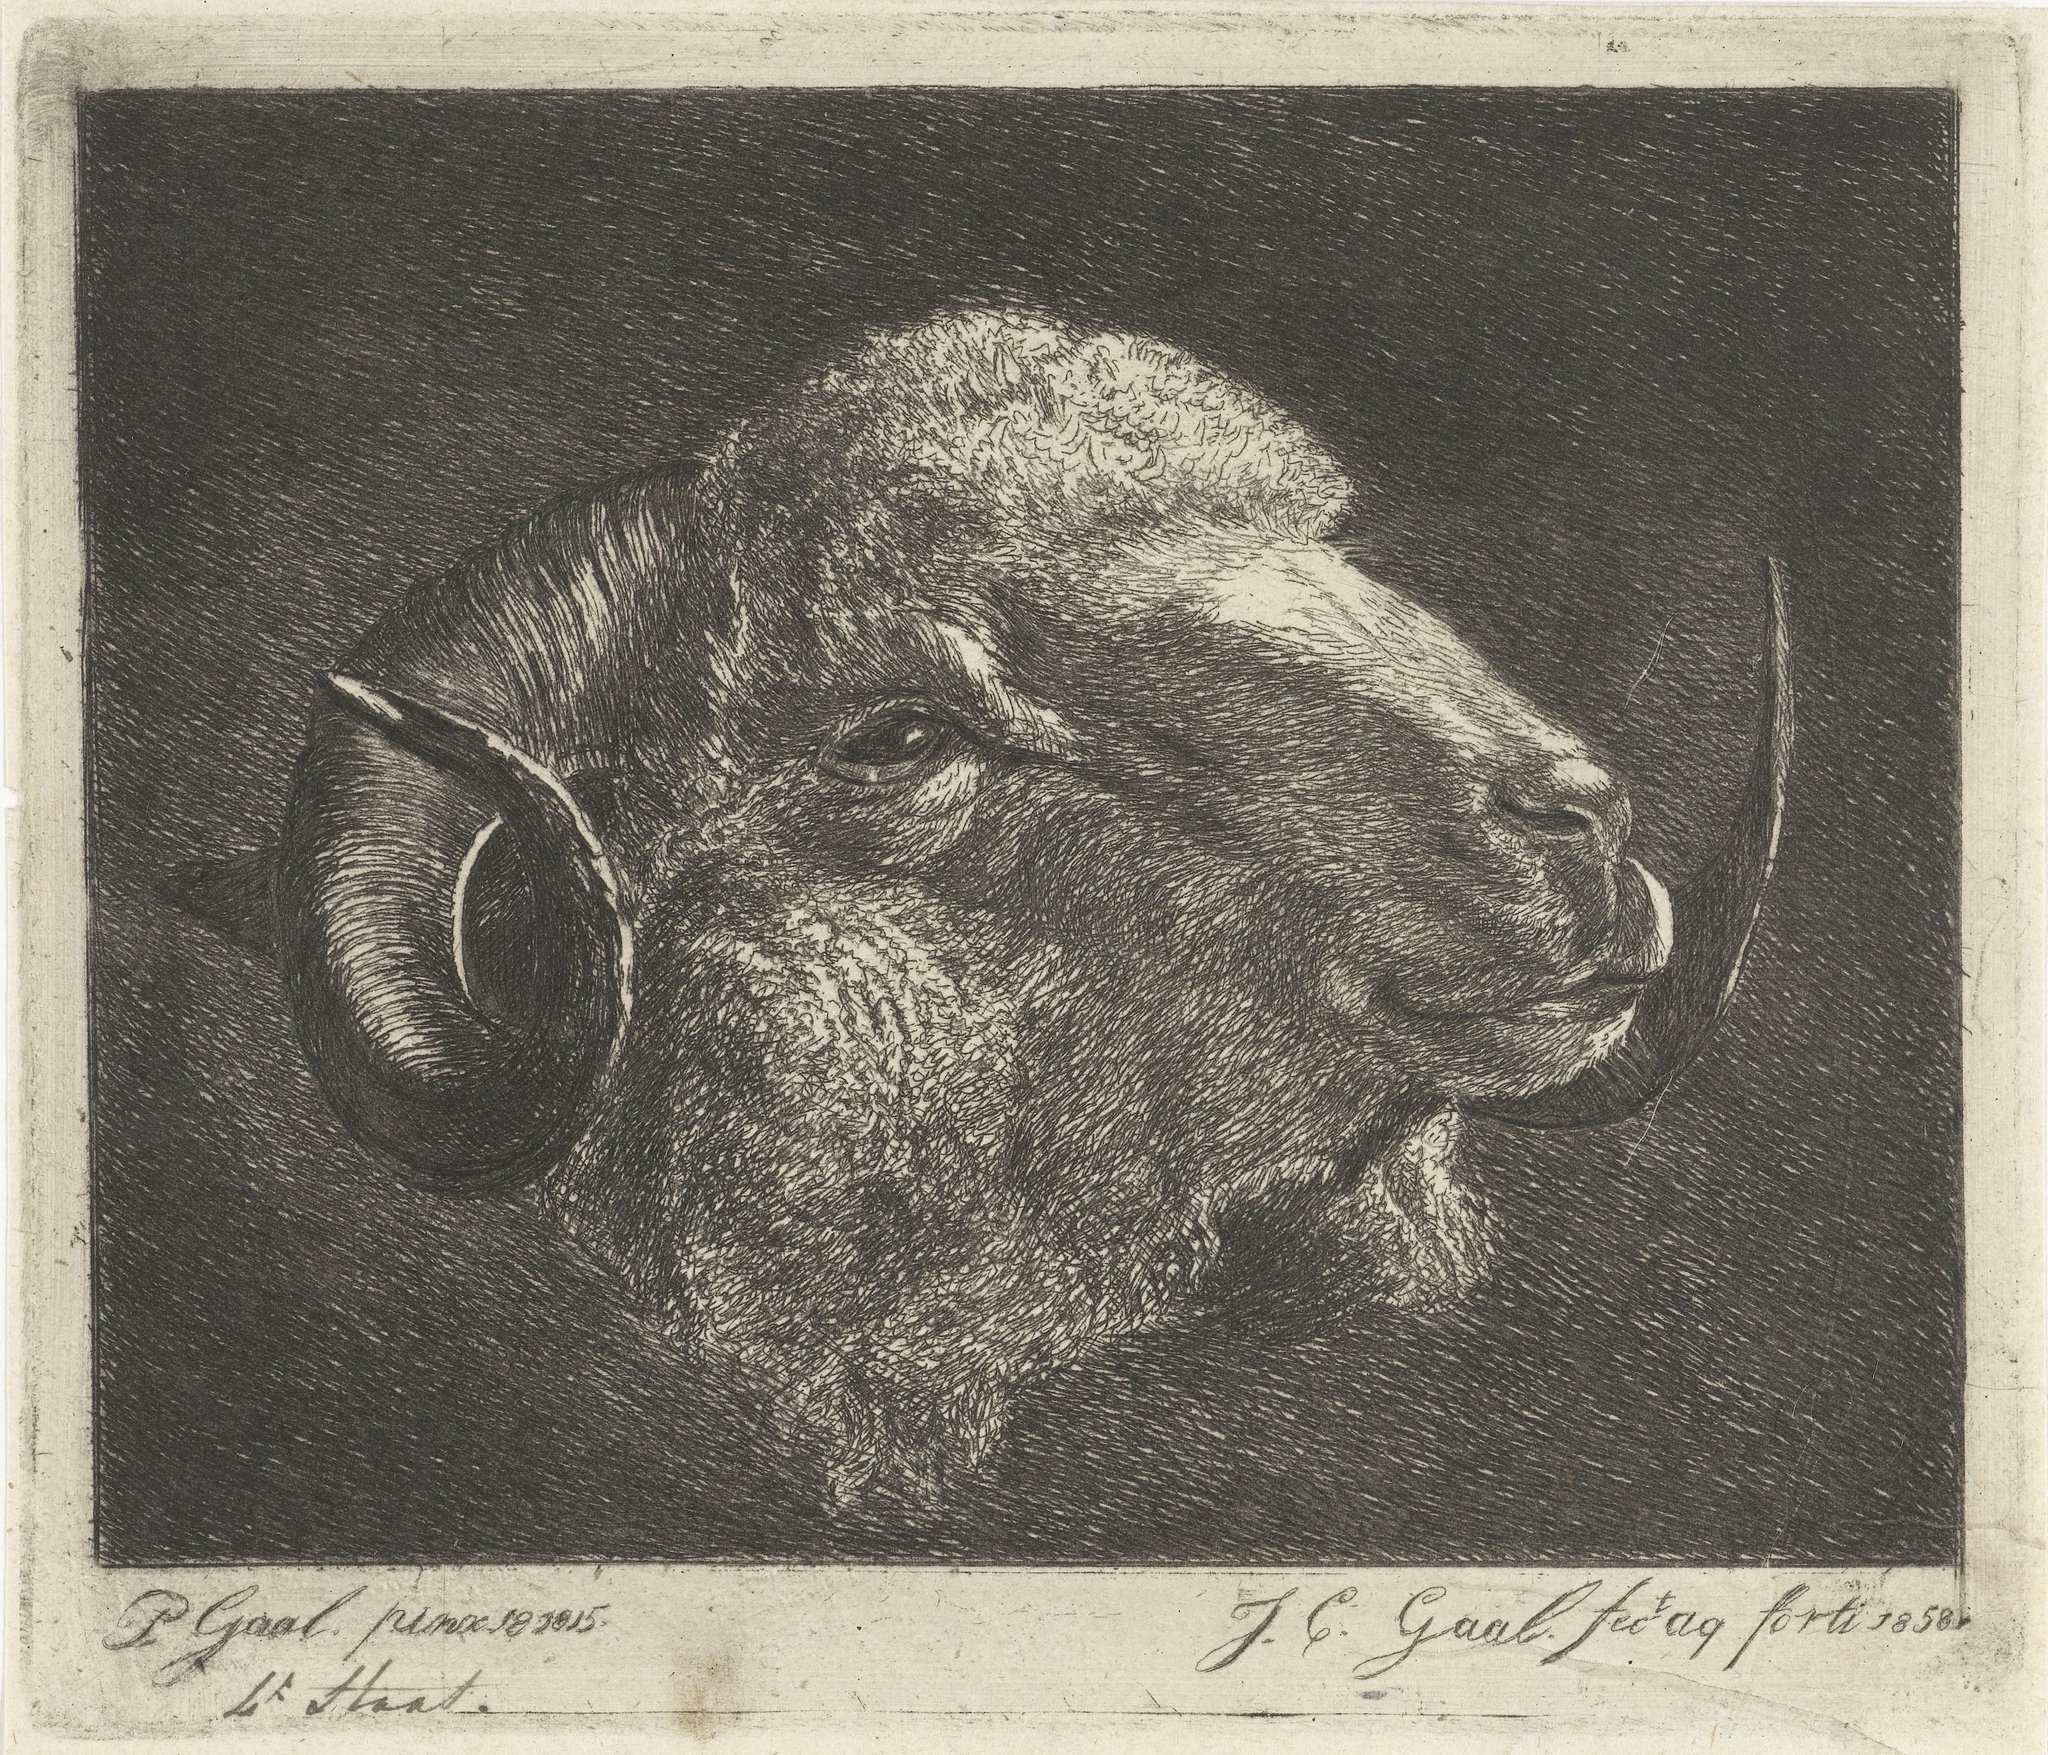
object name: print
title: Kop van een ram met naar achteren gedraaide hoorns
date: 1858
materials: paper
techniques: etching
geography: netherlands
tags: ram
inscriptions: collector's mark: Lugt 2228